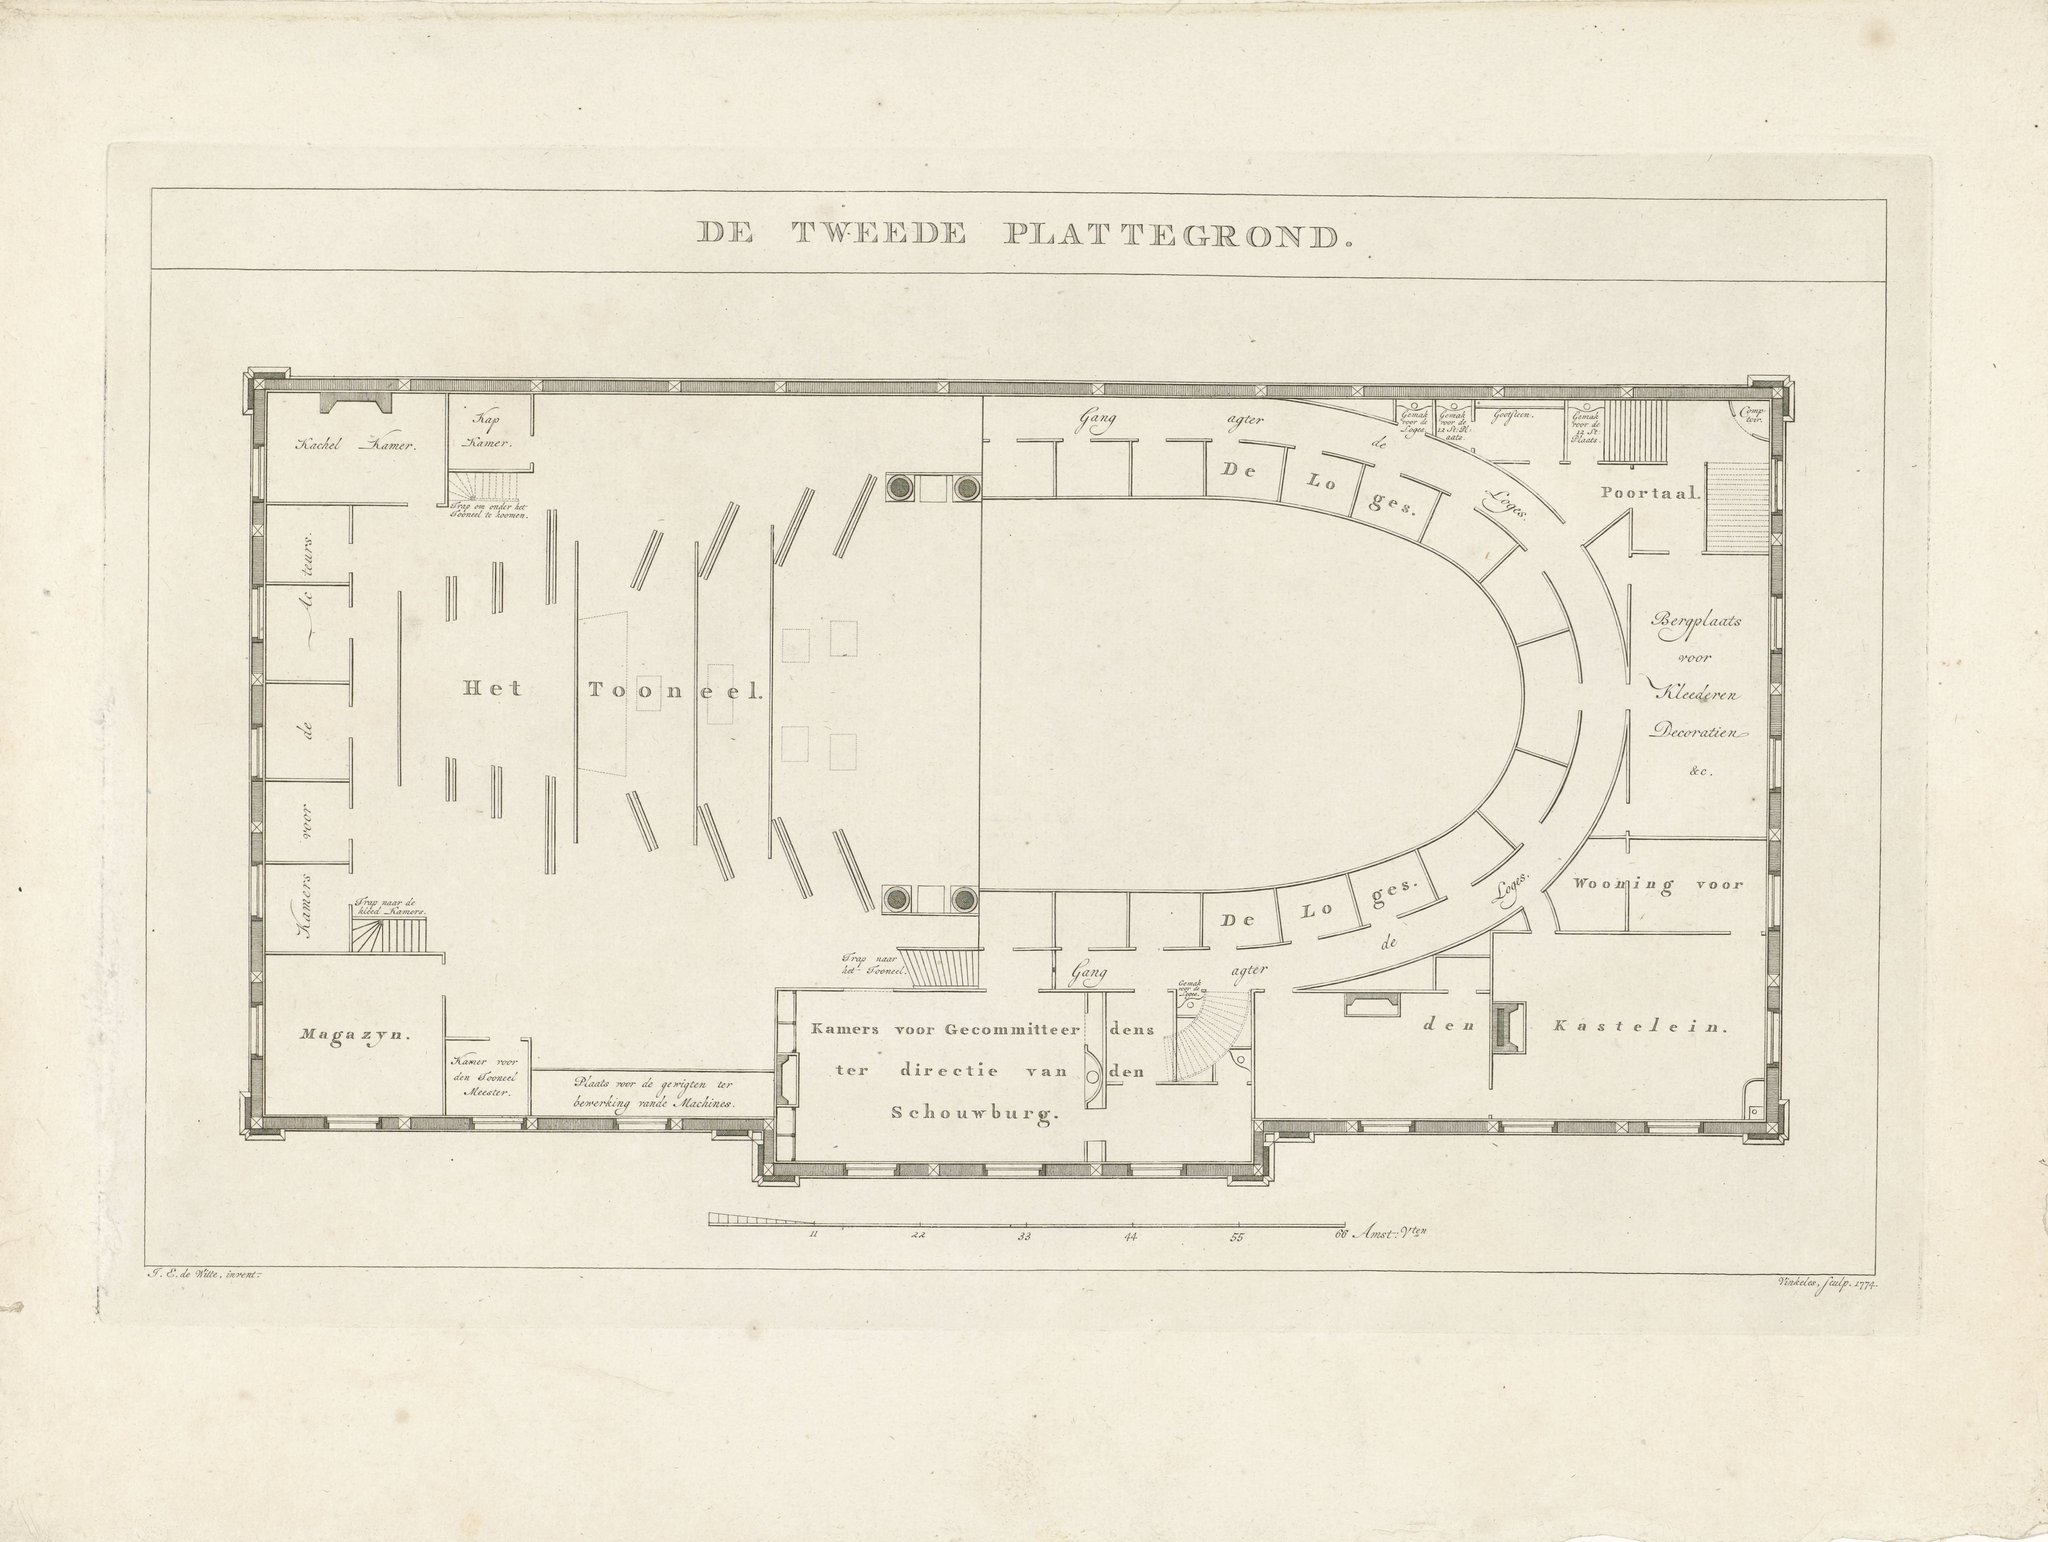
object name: print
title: De tweede plattegrond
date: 1774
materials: paper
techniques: etching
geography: amsterdam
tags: jacob eduard de witte, theatre (building), architectural design or model, plan ~ architecture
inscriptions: collector's mark: Lugt 2228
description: Plattegrond van de eerste verdieping van de Schouwburg. Onderdeel van een reeks van veertien platen van de nieuwe Schouwburg te Amsterdam, 1774.